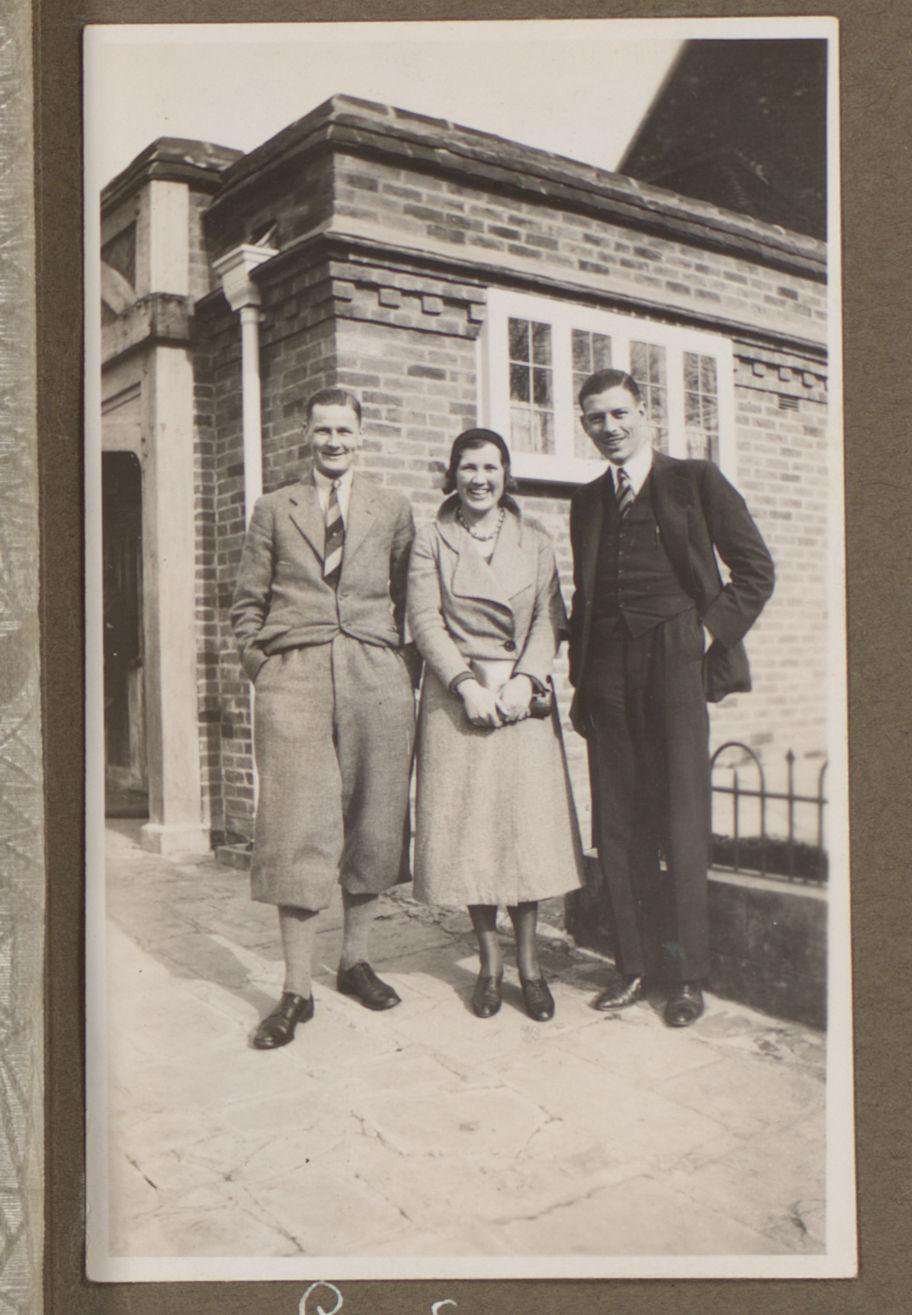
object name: album leaf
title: Gezelschap in Londen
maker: Anonymous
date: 1932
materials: paper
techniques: gelatin silver print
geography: london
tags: historical persons not known by name, london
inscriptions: inscription: ‘London.’